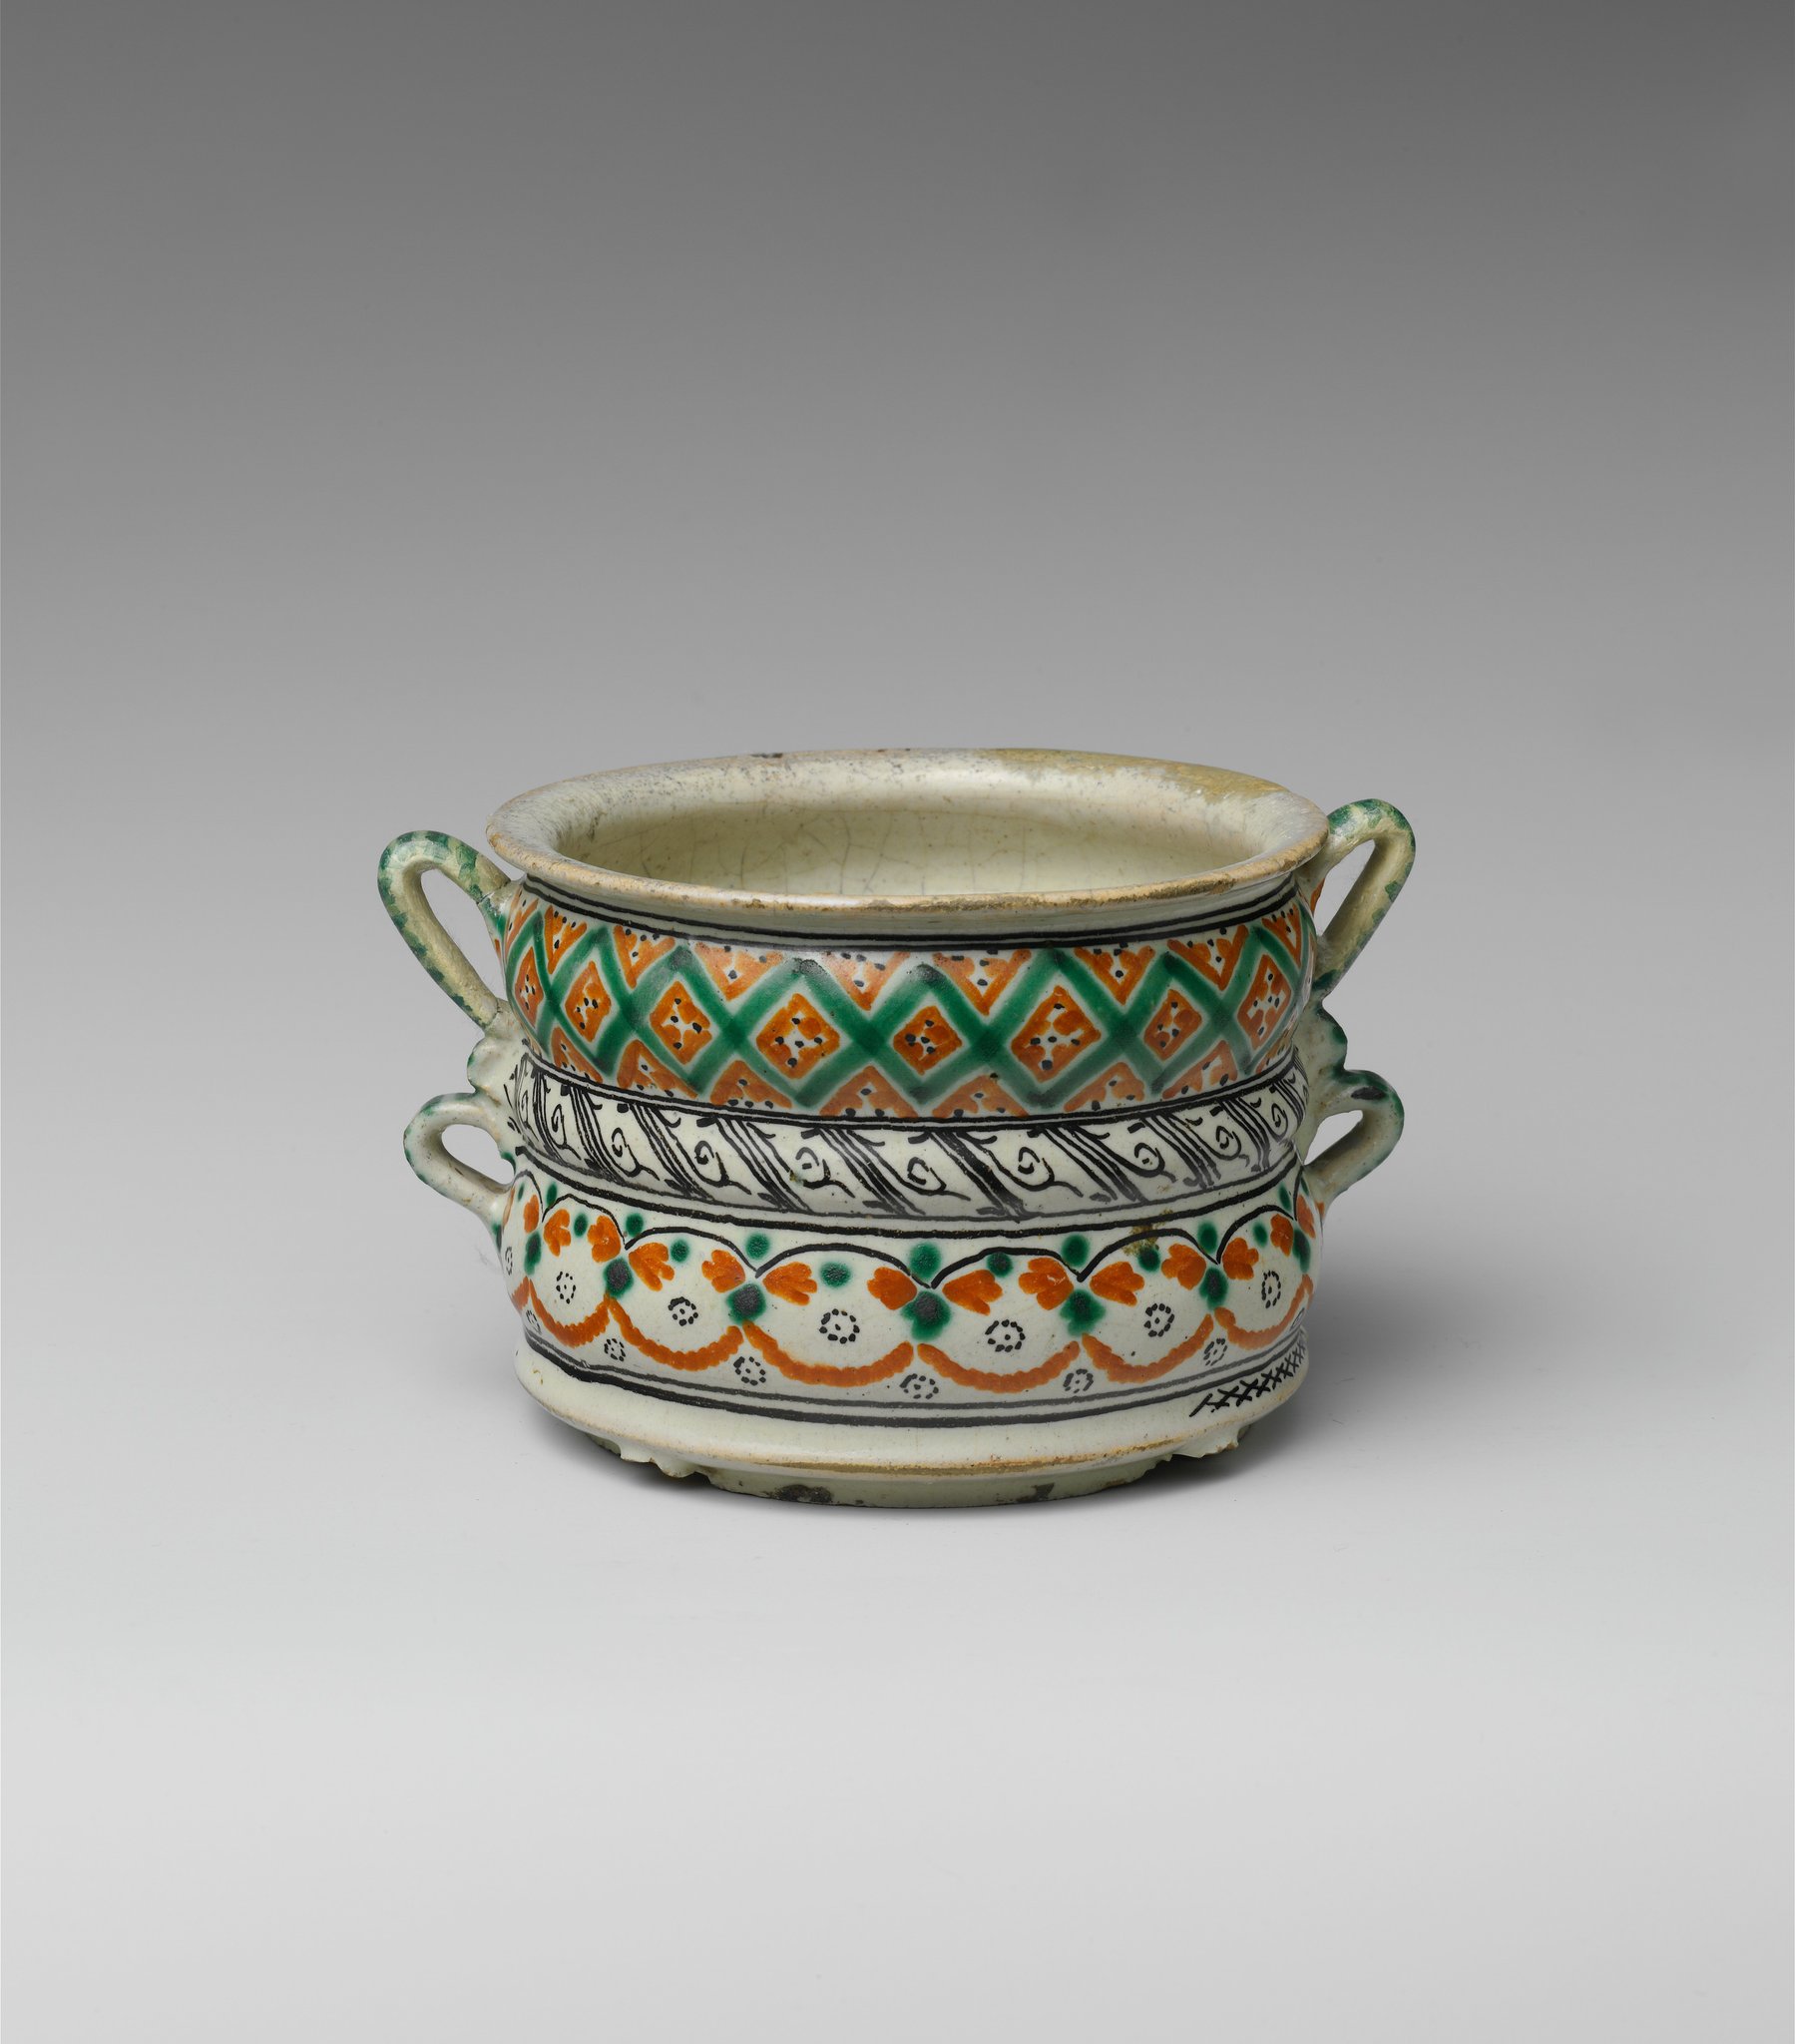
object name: cup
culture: mexican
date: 1845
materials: earthenware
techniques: glazing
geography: mexico